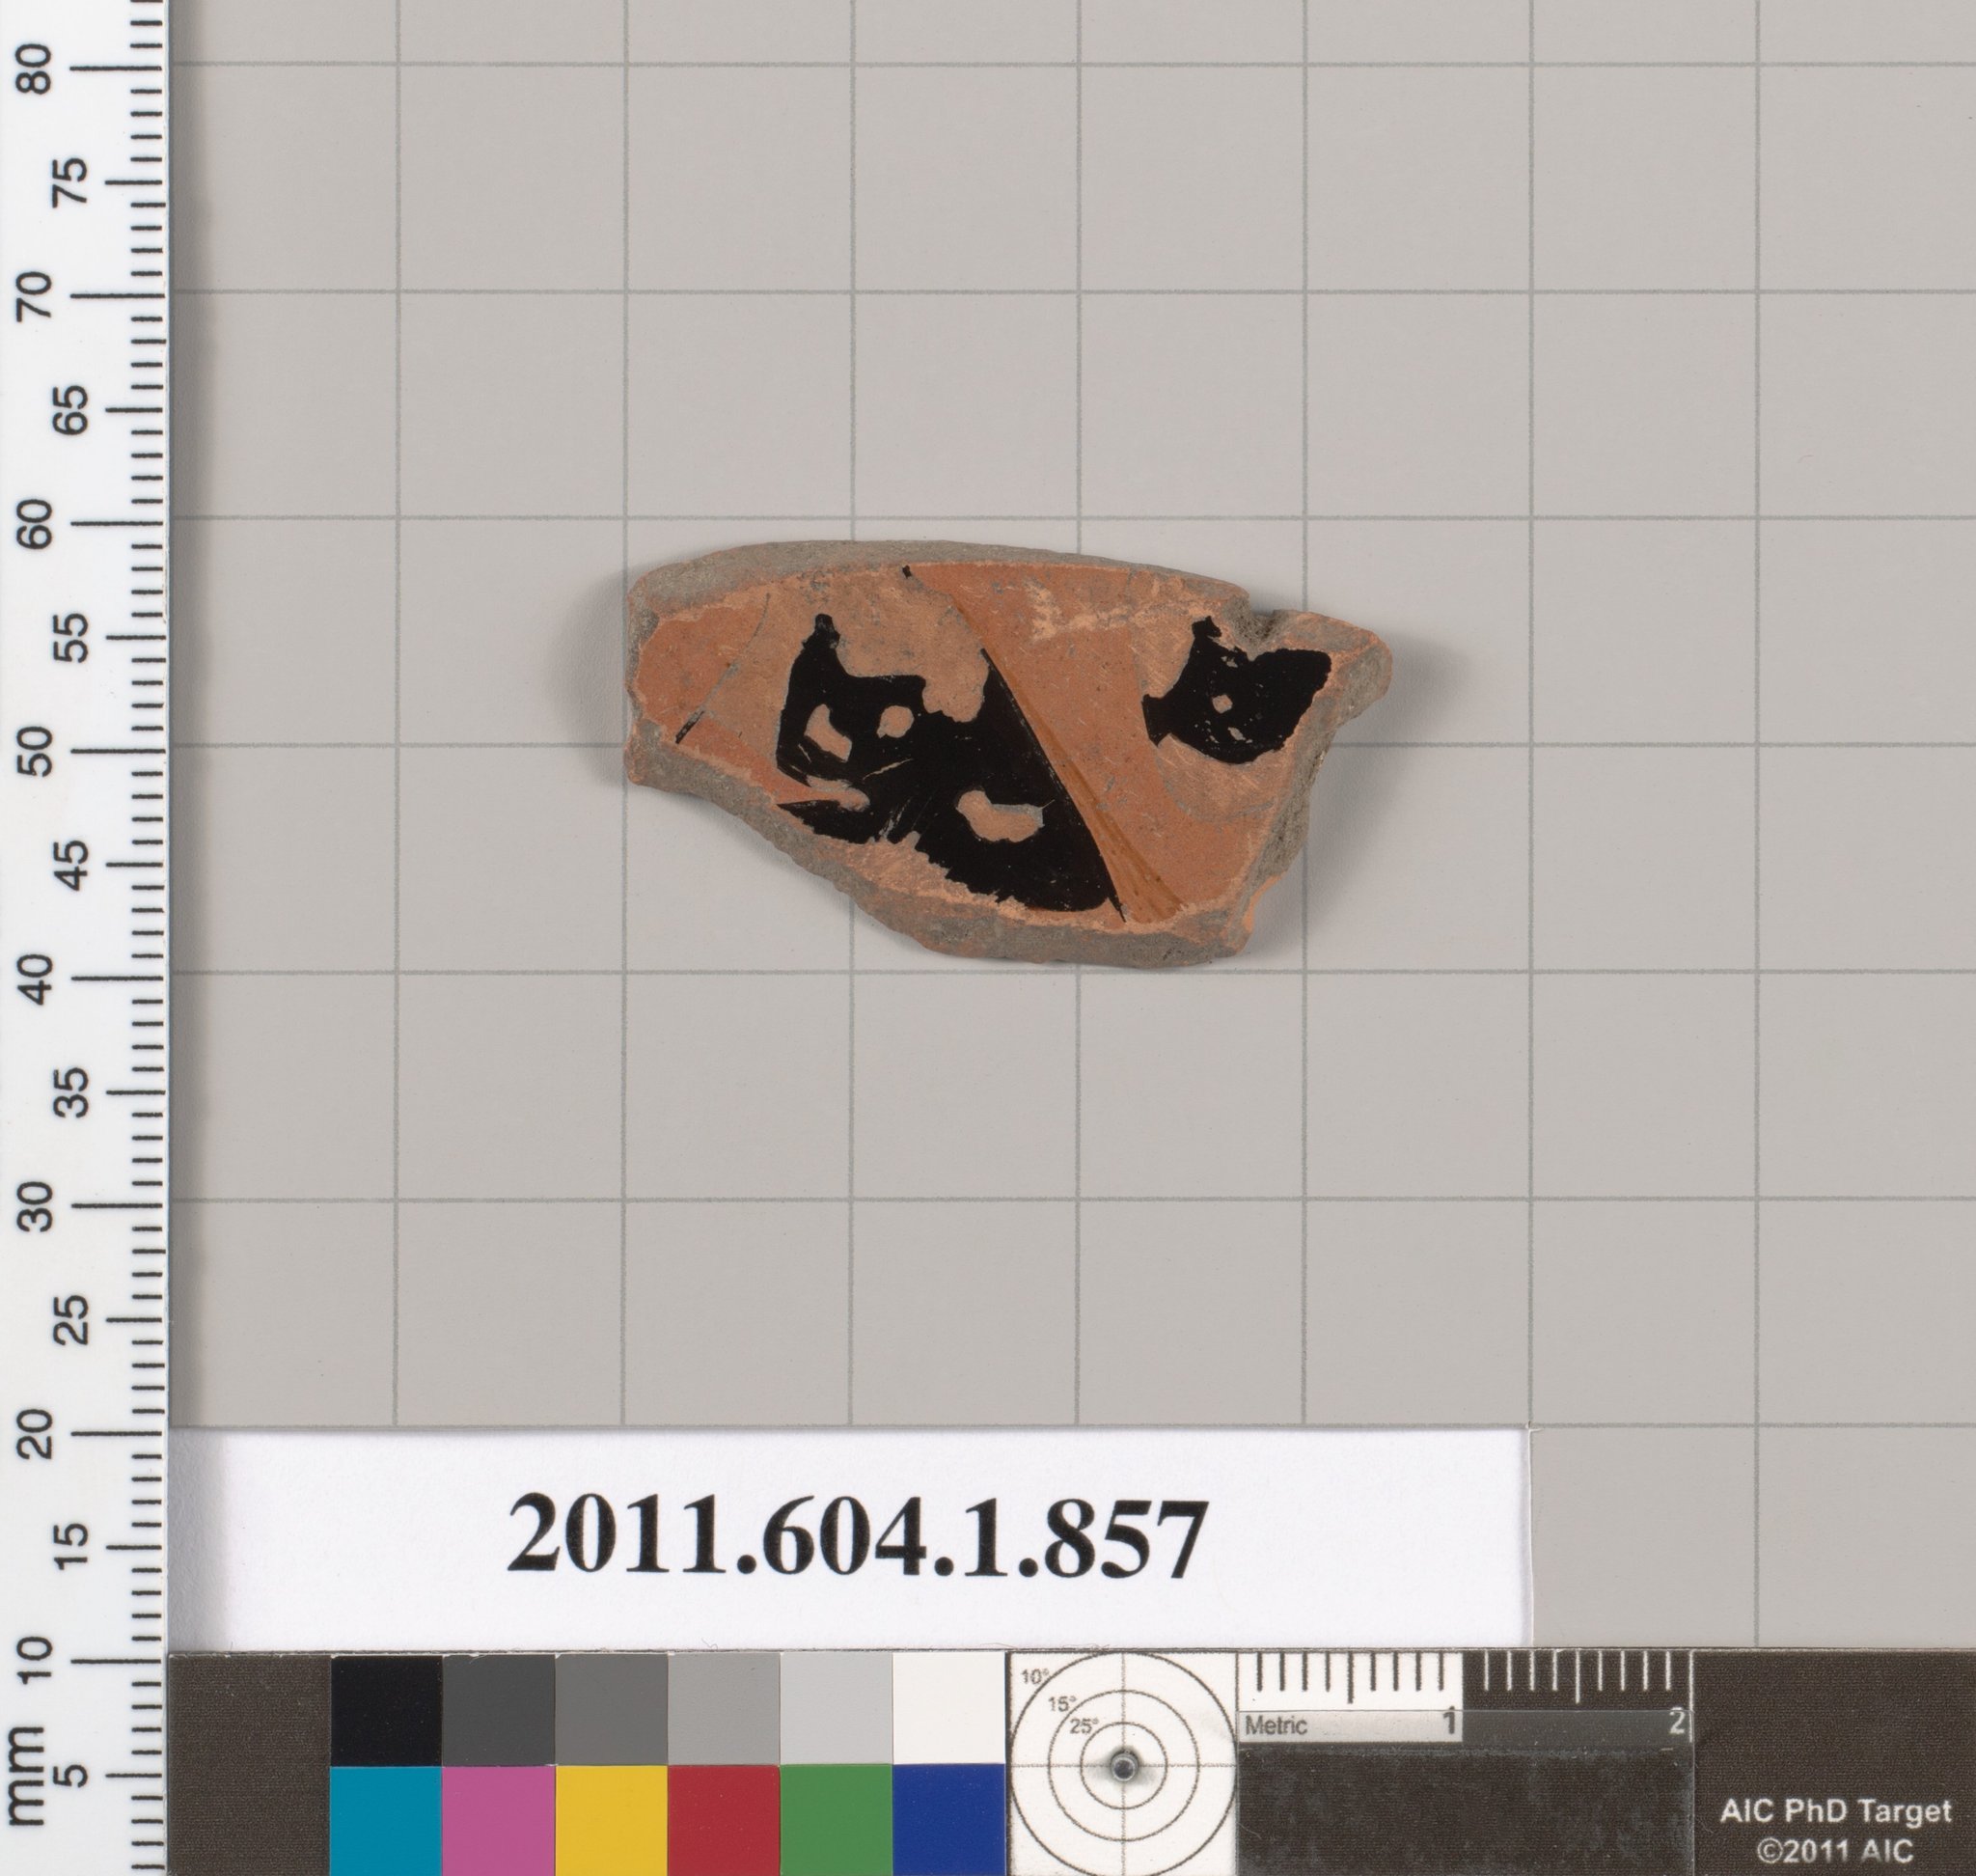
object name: kylix fragment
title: Terracotta fragment of a kylix (drinking cup)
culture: greek, attic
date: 475-451 BCE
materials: terracotta